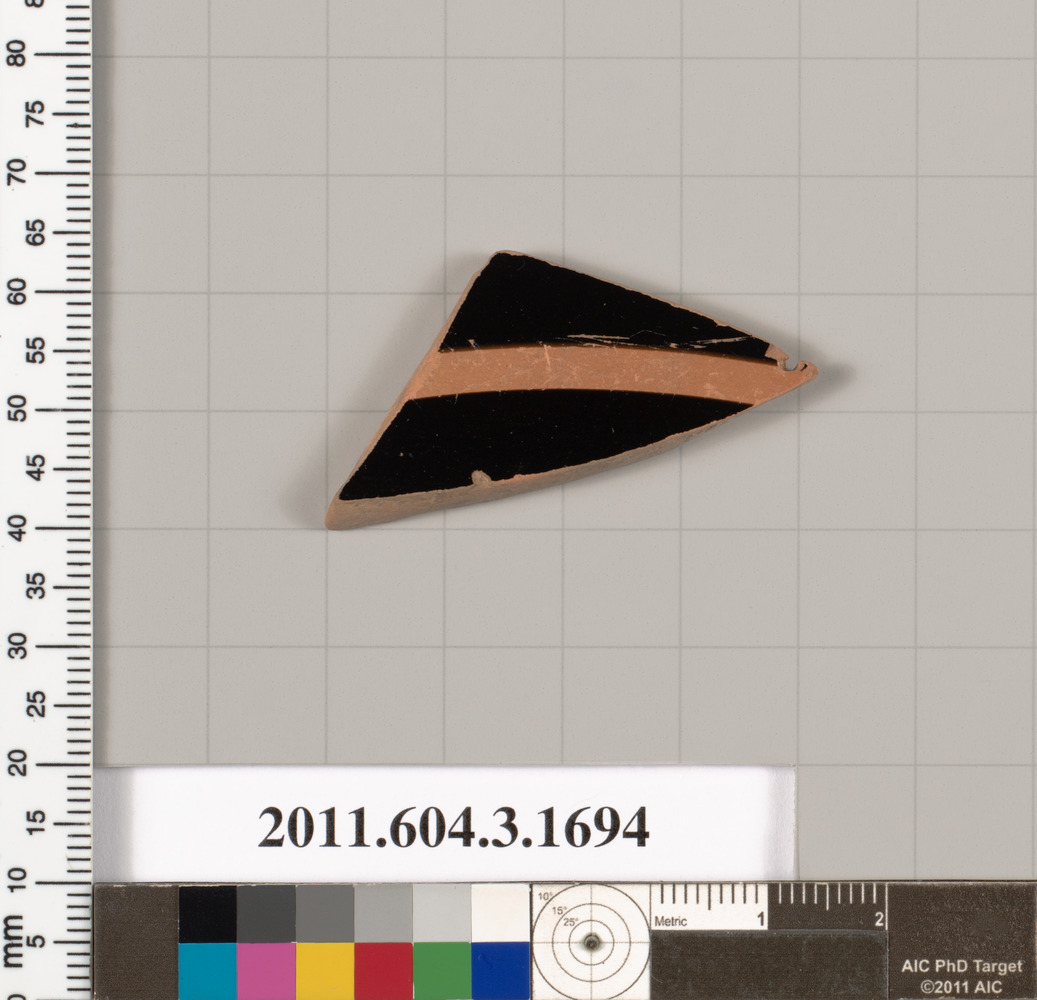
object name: kylix fragment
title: Terracotta fragment of a kylix: Band or lip cup (drinking cup)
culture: greek, attic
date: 550-526 BCE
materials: terracotta